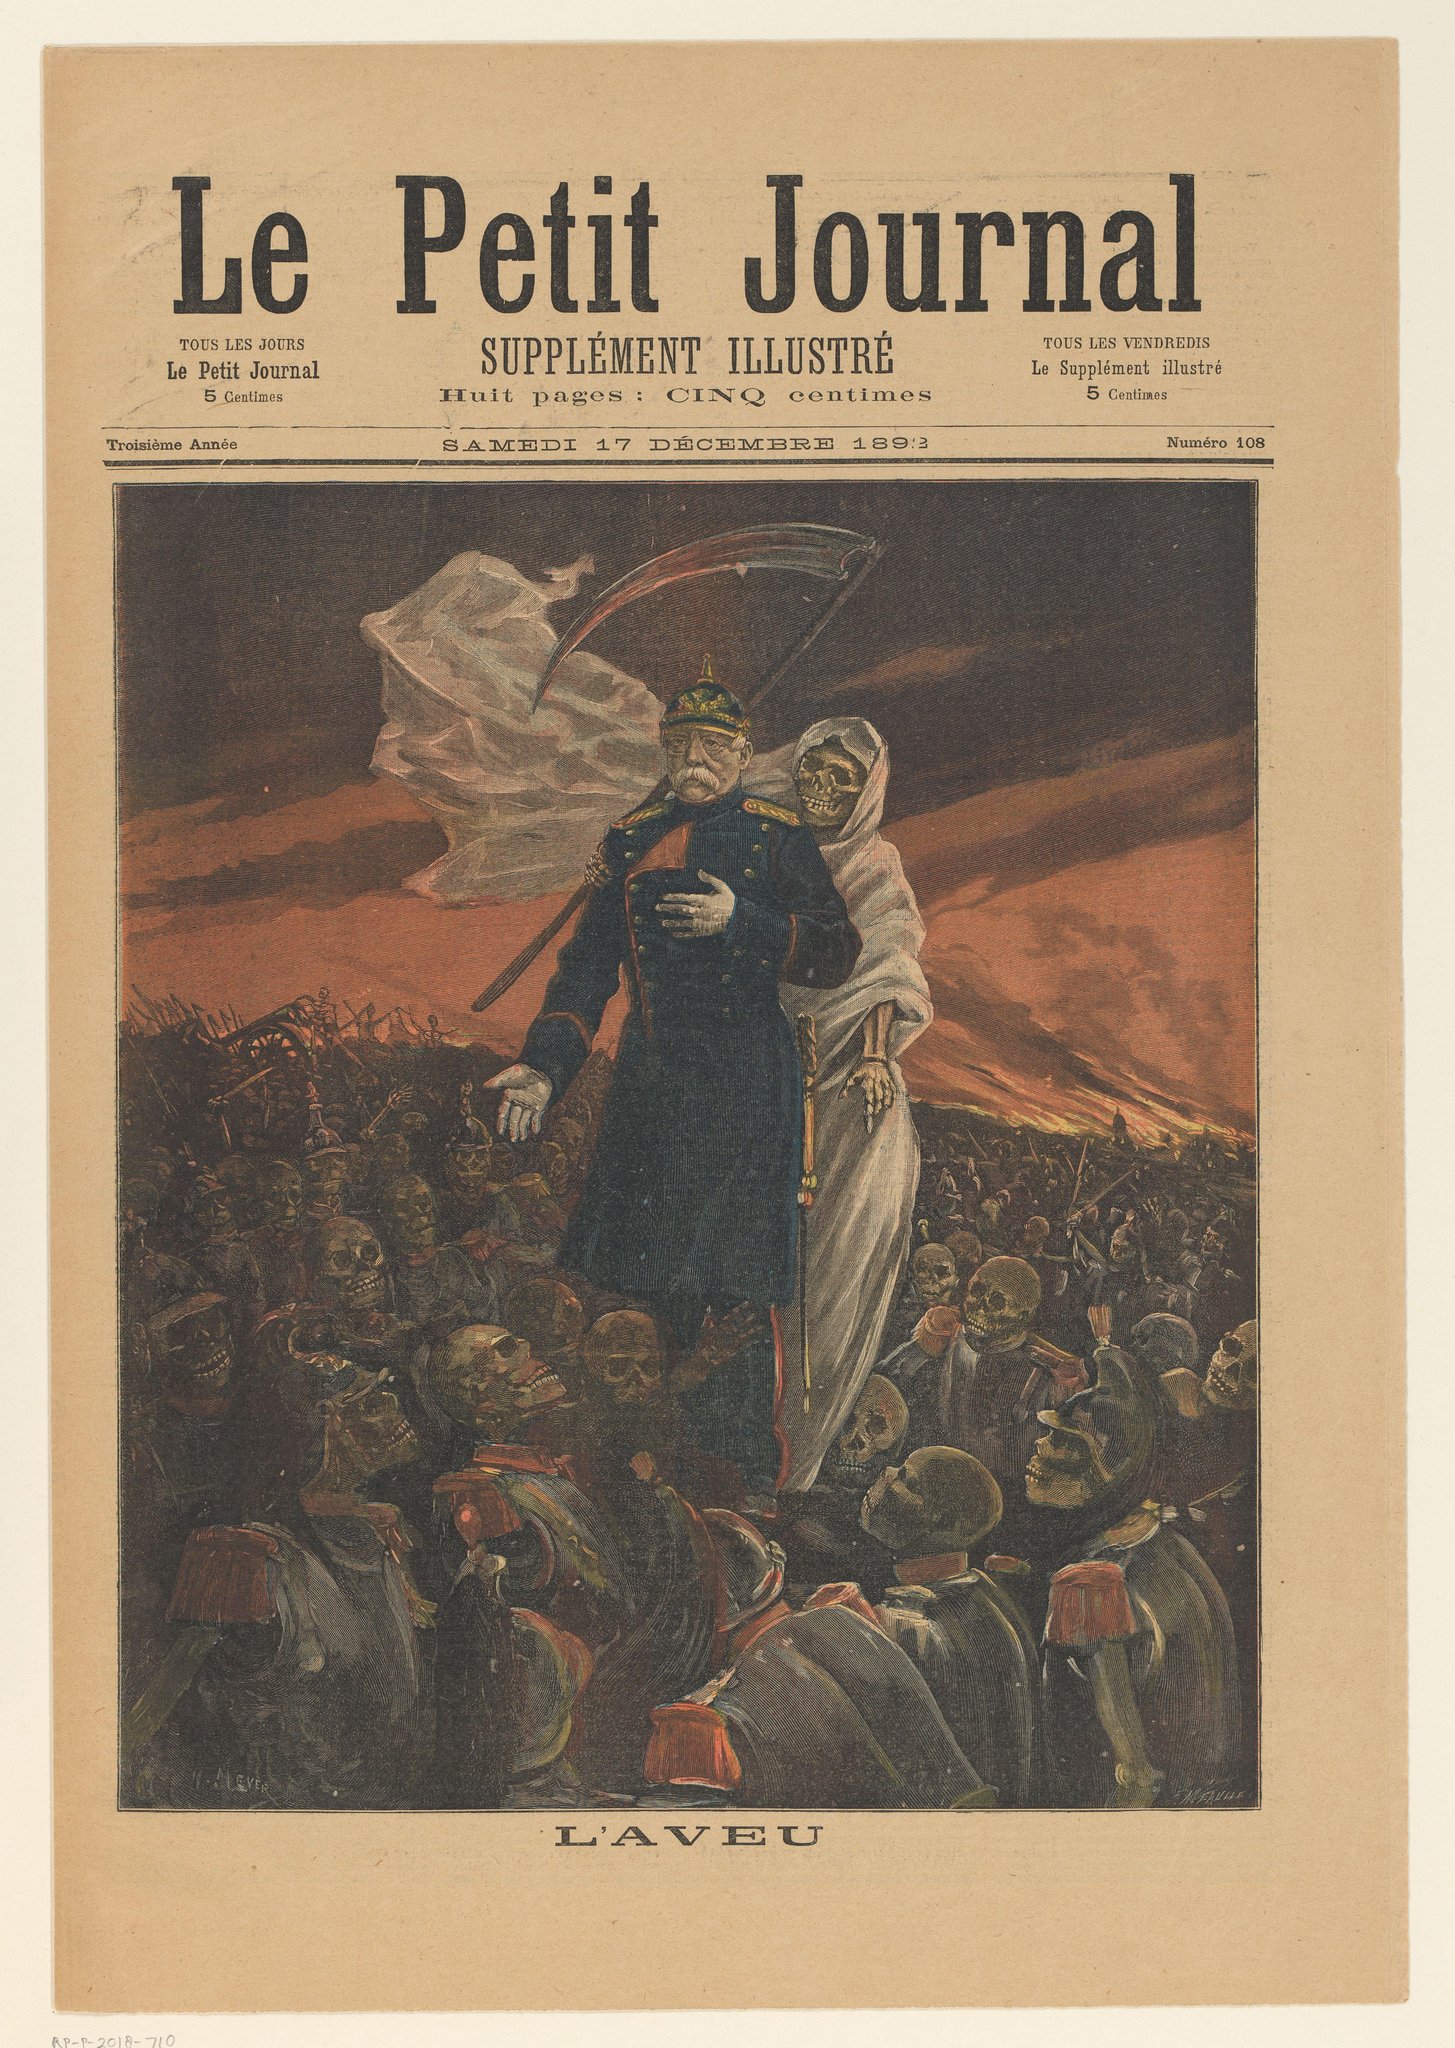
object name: cartoon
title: Le Petit Journal / Supplément Illustré / Samedi 17 Décembre 1892 / Numéro 108 / L'Aveu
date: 1892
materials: paper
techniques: hand coloring, printed materials, engraving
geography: france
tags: berlin, wilhelm i (keizer van duitsland), death as skeleton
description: 'De bekentenis', keizer Wilhelm I met de Dood en staande tussen de slachtoffers van de oorlog. Illustratie op voorzijde van de krant 'Le Petit Journal' van 17 december 1892